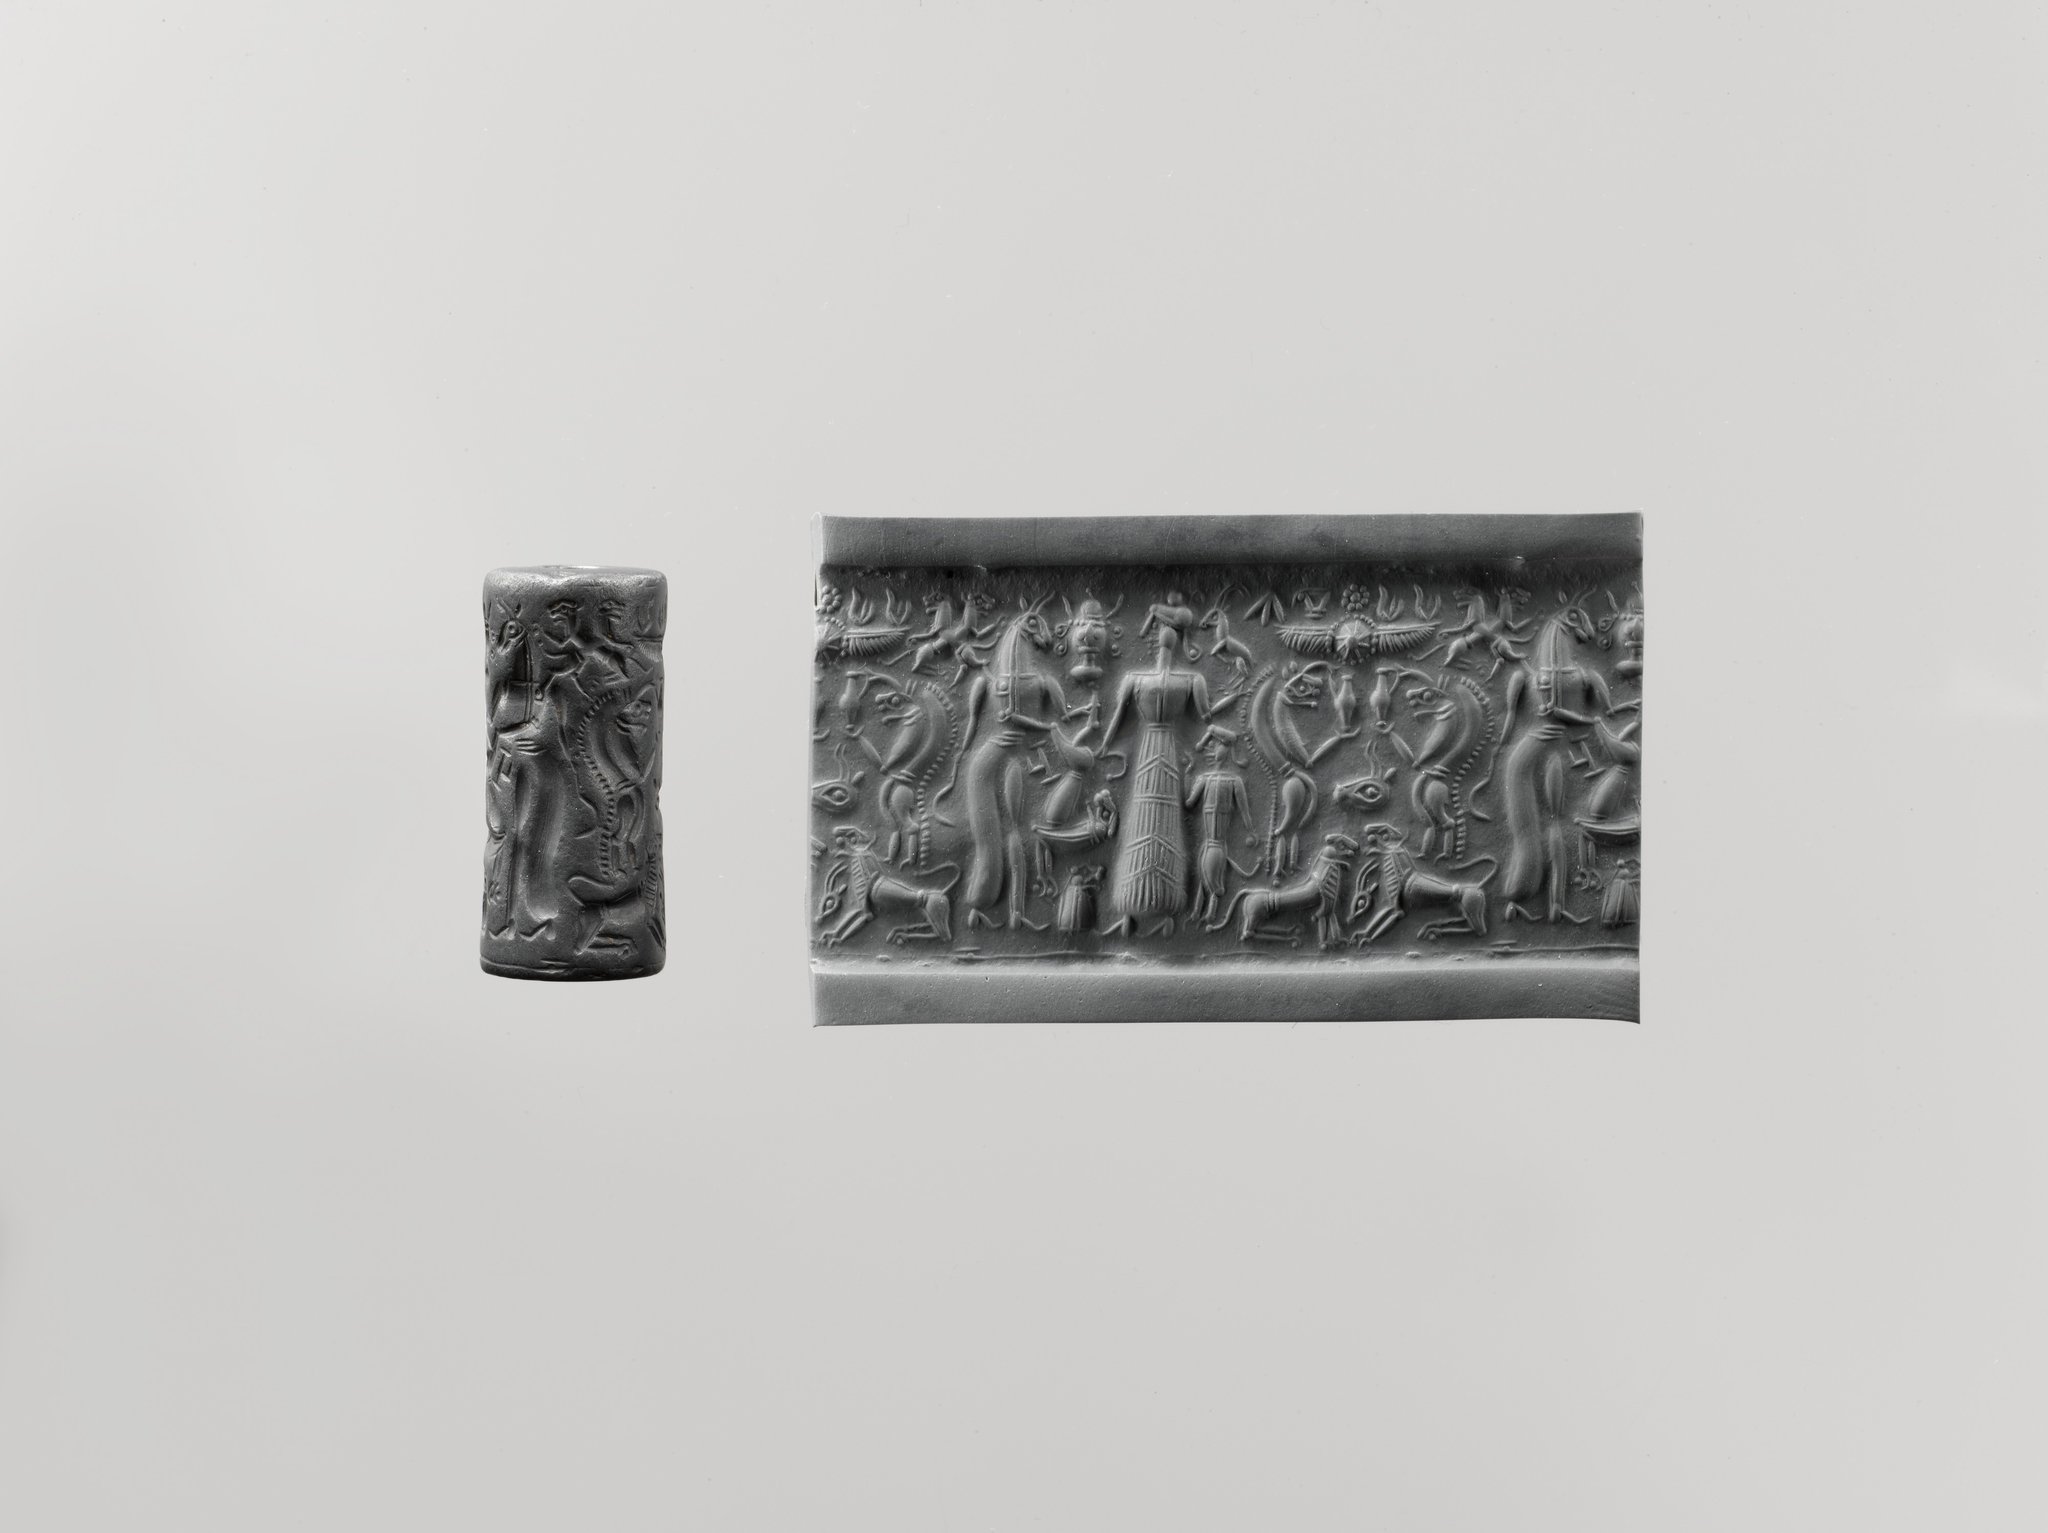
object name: cylinder seal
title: Cylinder seal and modern impression: demons and animals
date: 1400-1301 BCE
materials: mineral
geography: cyprus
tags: horses,lions